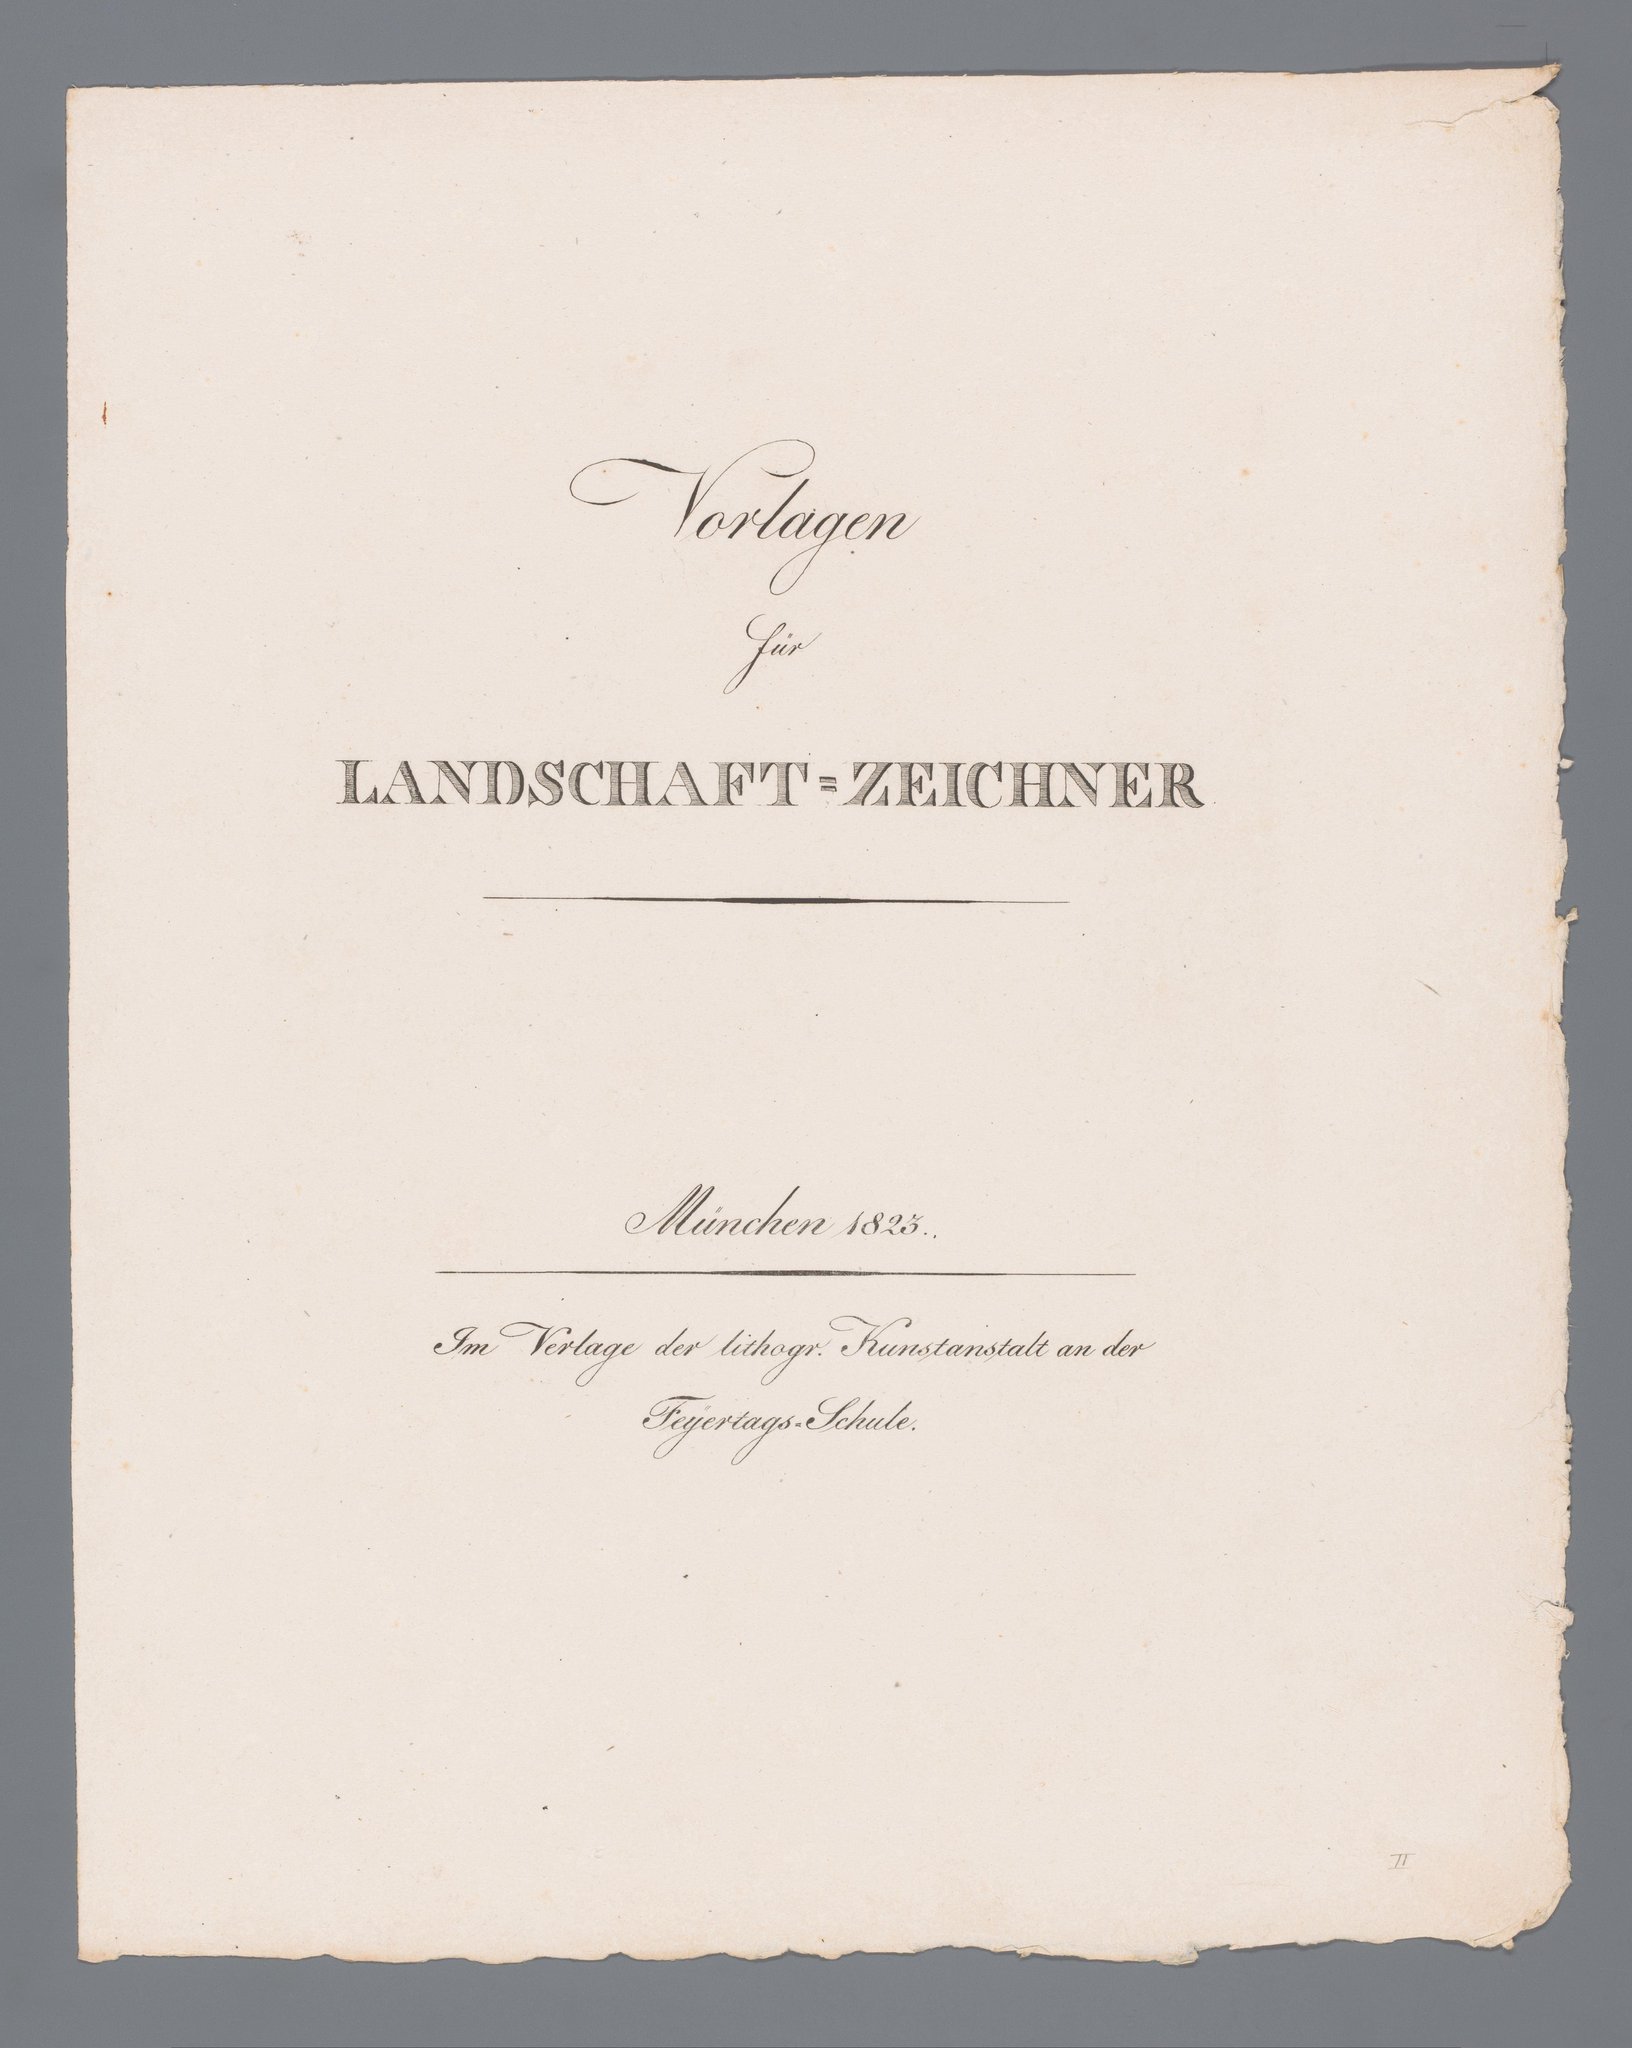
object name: titelprent, frontispice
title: Voorbeelden voor de landschapstekenaar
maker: max josef wagenbauer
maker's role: print maker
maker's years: 1774-1829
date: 1823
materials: paper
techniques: lithograph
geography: munich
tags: trees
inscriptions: date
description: Onderdeel van een tweedelige serie waarvan het tweede deel bestaat uit een titelprent en twaalf voorstellingen van takken, bladeren, bomen en landschappen.